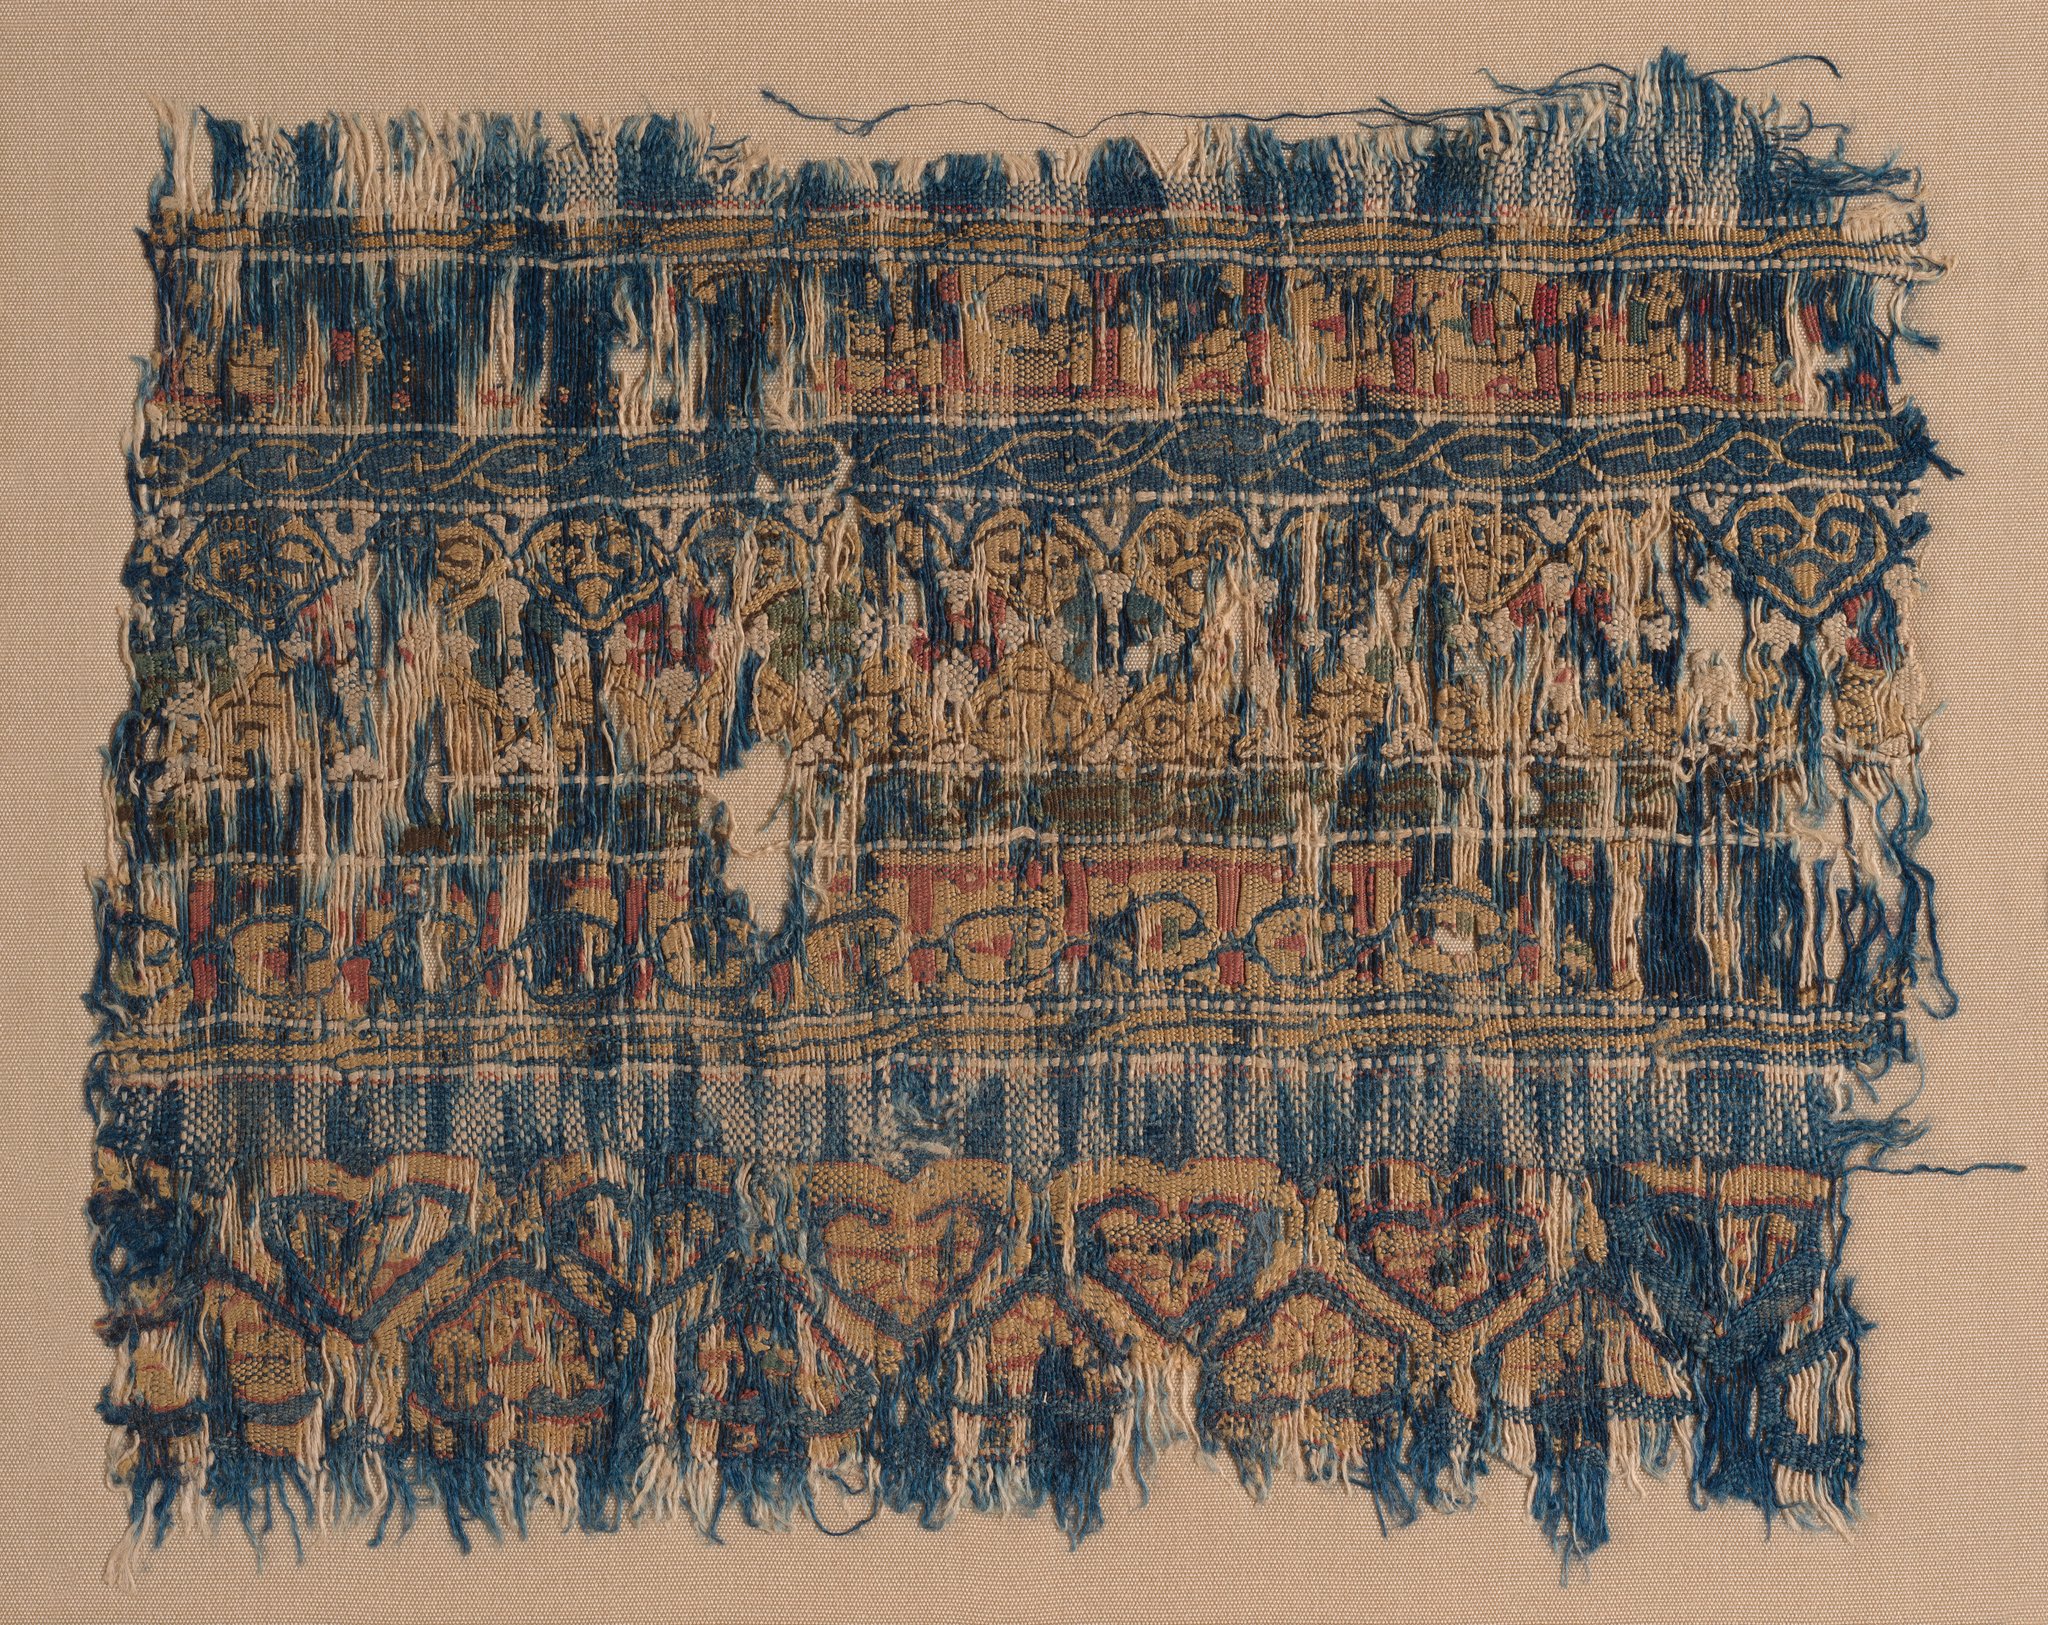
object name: textile fragment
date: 1001-1200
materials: linen, silk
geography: egypt